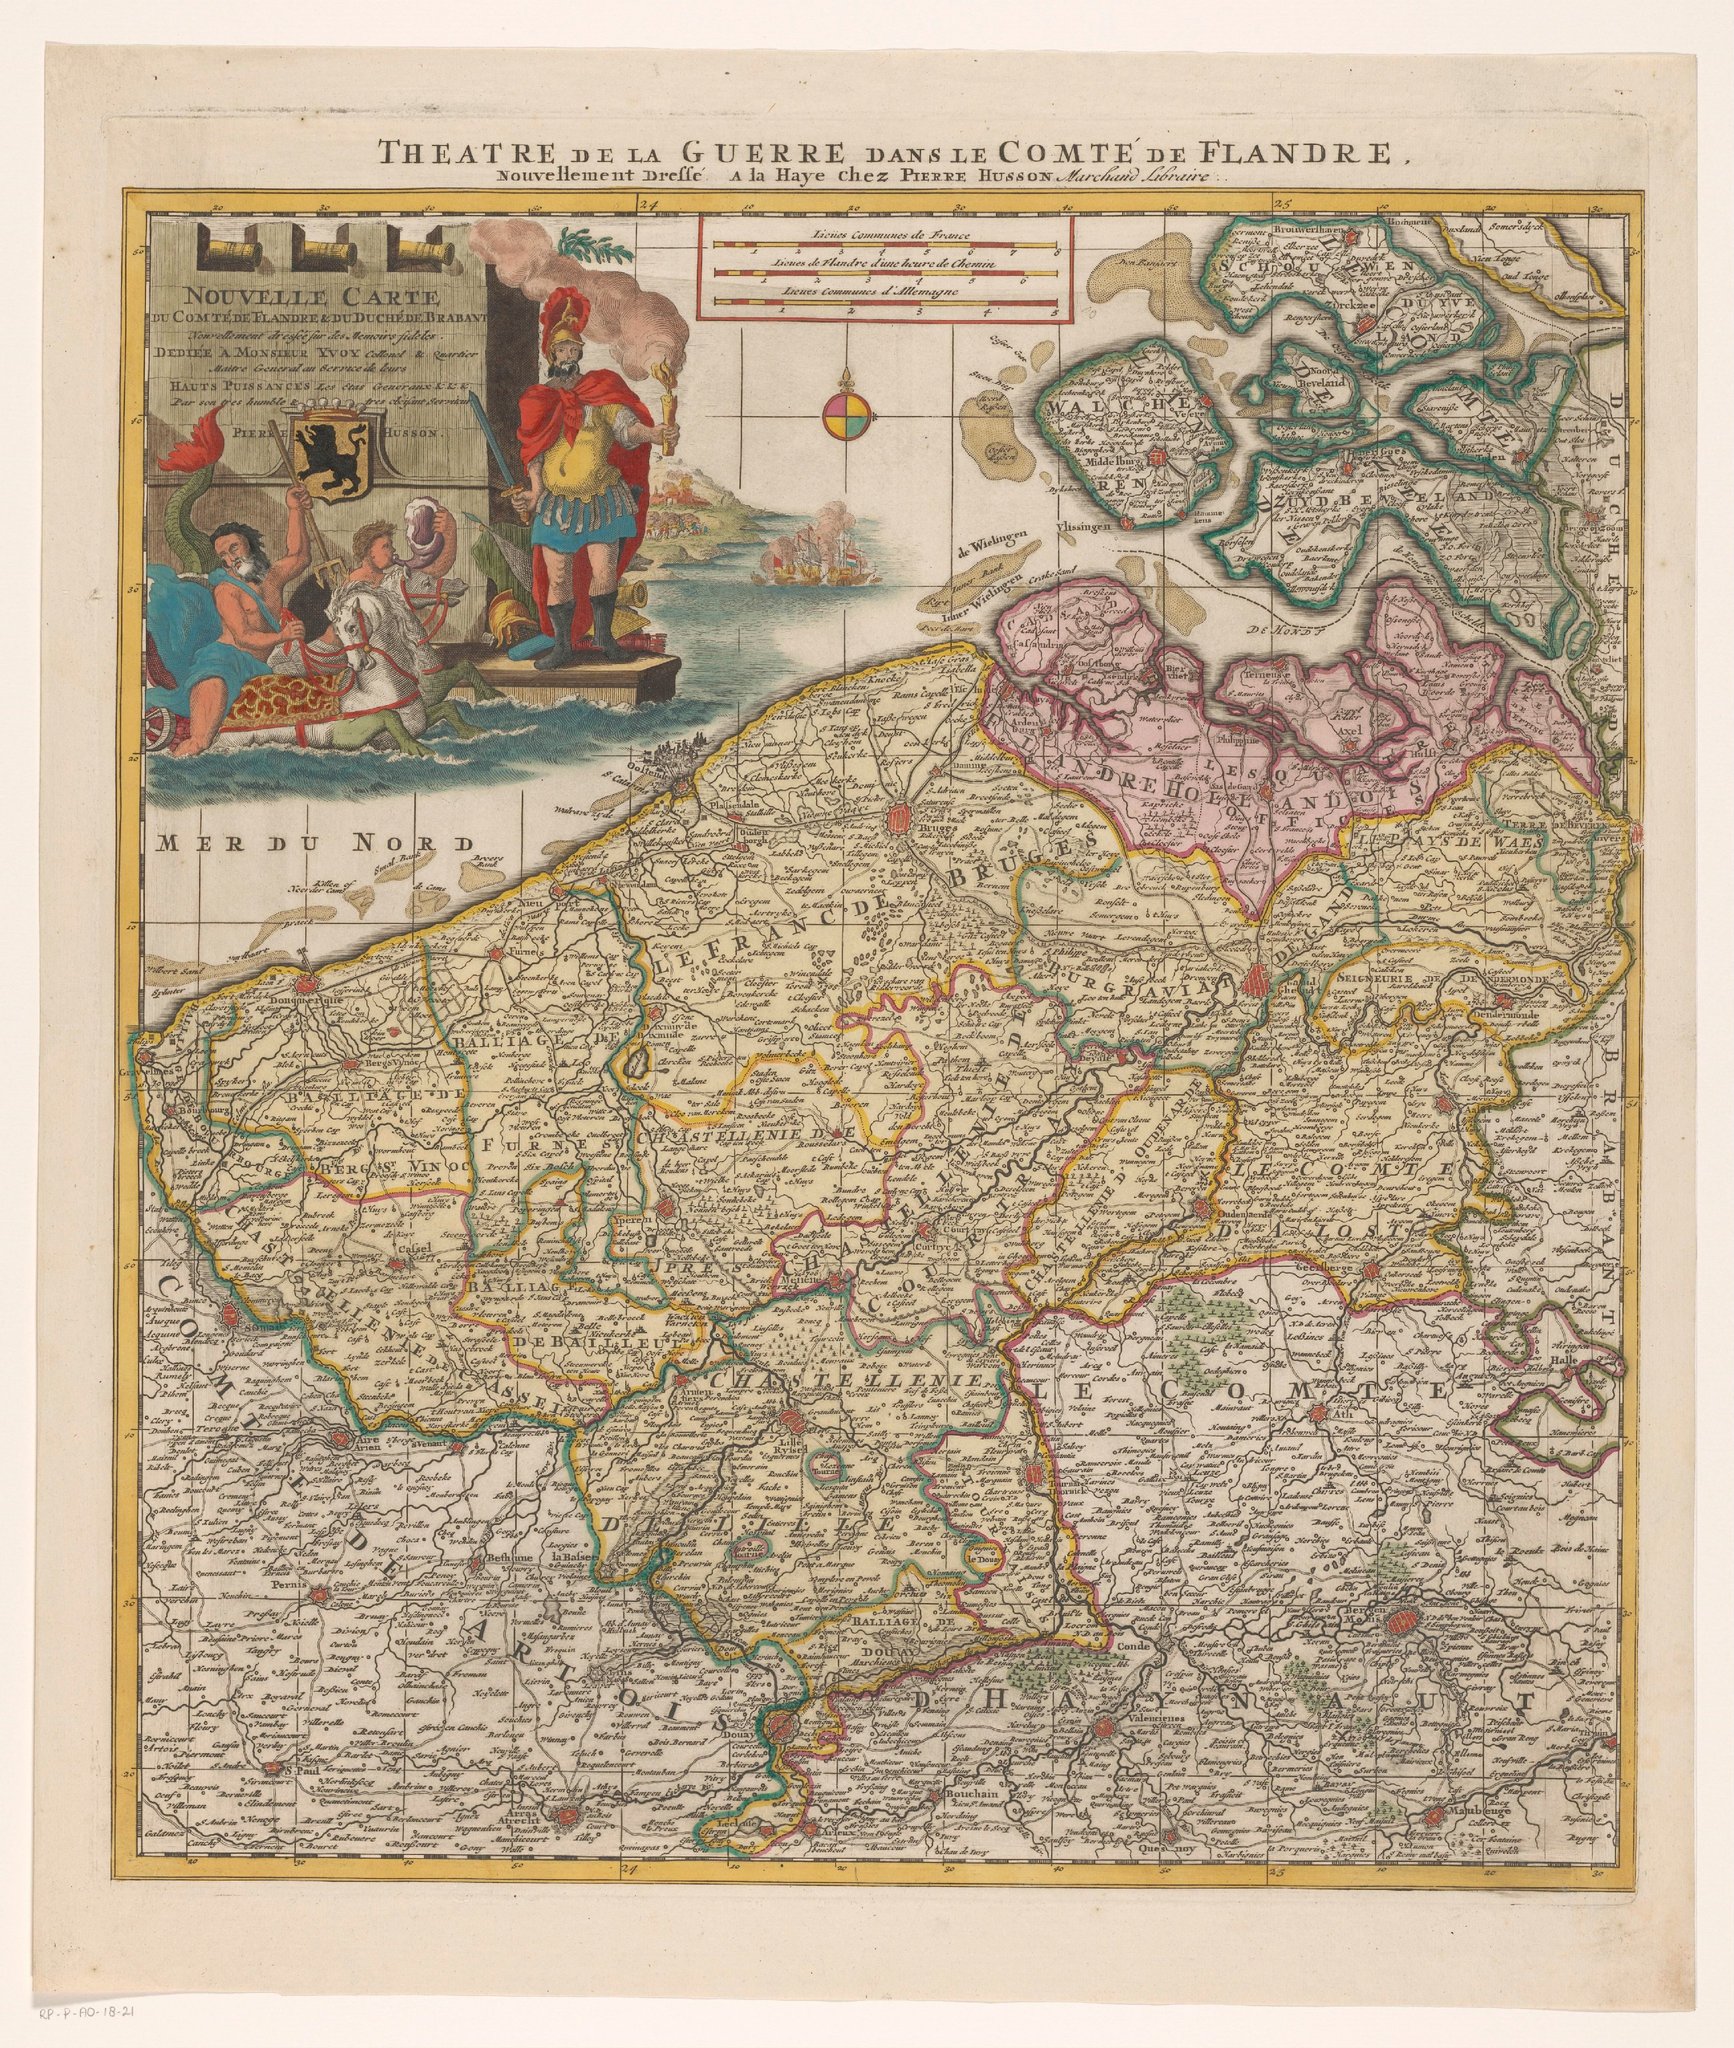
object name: map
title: Kaart van het graafschap Vlaanderen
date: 1706-1733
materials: paper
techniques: engraving, etching, hand coloring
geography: the hague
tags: (story of) neptune (poseidon), maps of separate countries or regions, merman, coat of arms (as symbol of the state, etc.) (+ province; provincial), zeeland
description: Kaart van het graafschap Vlaanderen, waar het beleg van Oostende in 1706 op is aangegeven. Boven de kaart een titel en linksboven een cartouche met tweede titel. In het cartouche het wapen van het graafschap Vlaanderen en eromheen een voorstelling met een meerman, een Romeinse soldaat en Neptunes, met op de achtergrond een zeeslag. Boven, in het midden, een kader met drie schaalstokken: 8 Lieües Communes de France / 6 1/2 Lieües de Flandre d'une heure de Chemin / 5 Lieües Communes d'Allemagne. De kaart is voorzien van een coördinaten-net en een gradenverdeling langs de randen.